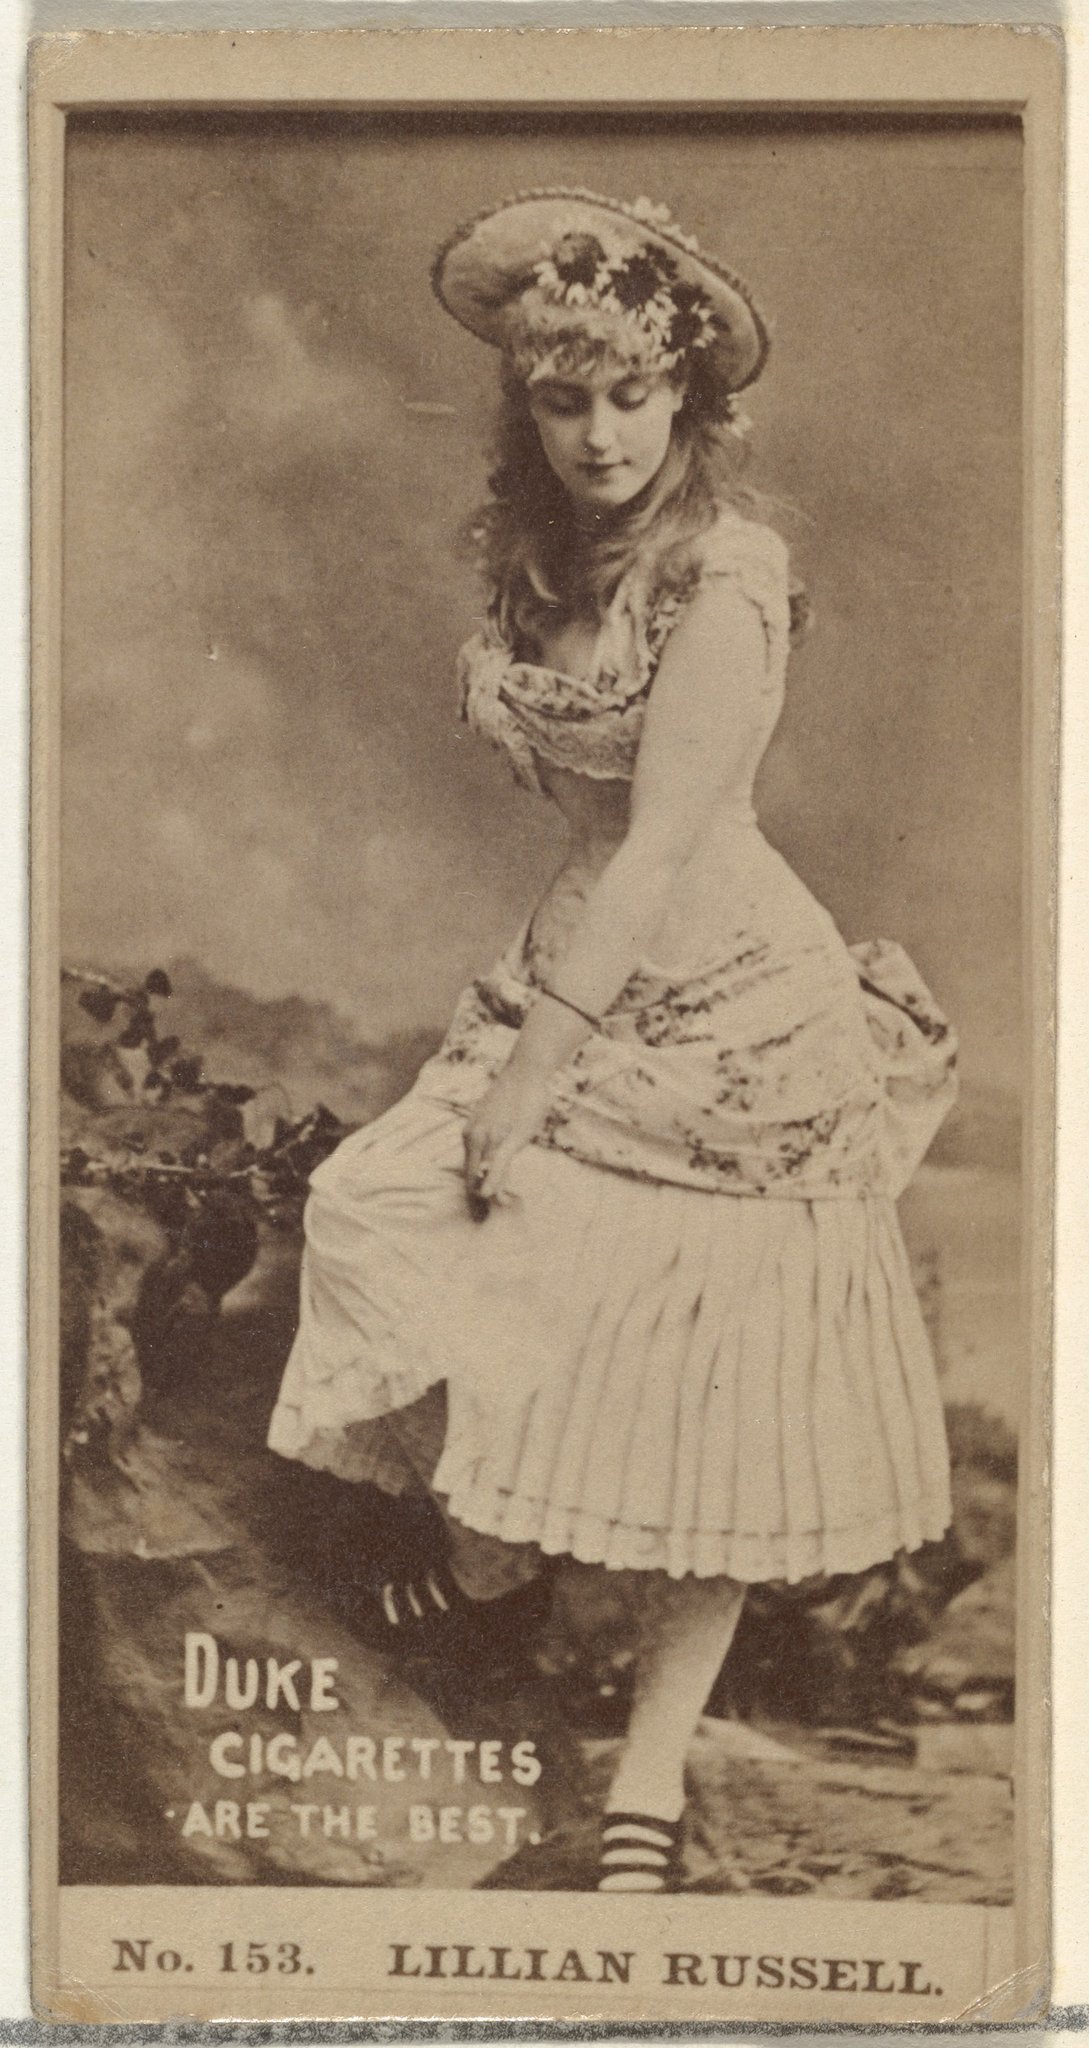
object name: photograph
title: Card Number 153, Lillian Russell, from the Actors and Actresses series (N145-6) issued by Duke Sons & Co. to promote Duke Cigarettes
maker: w. duke, sons & co.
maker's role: publisher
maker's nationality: american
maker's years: 1870-1920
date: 1880-1889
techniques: albumen silver print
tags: portraits,women,actresses